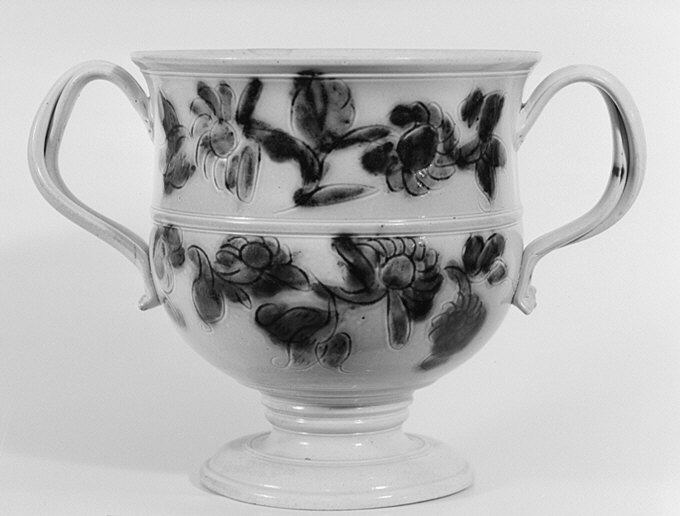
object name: cup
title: Two-handled cup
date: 1750-1770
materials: stoneware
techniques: salt glaze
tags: flowers